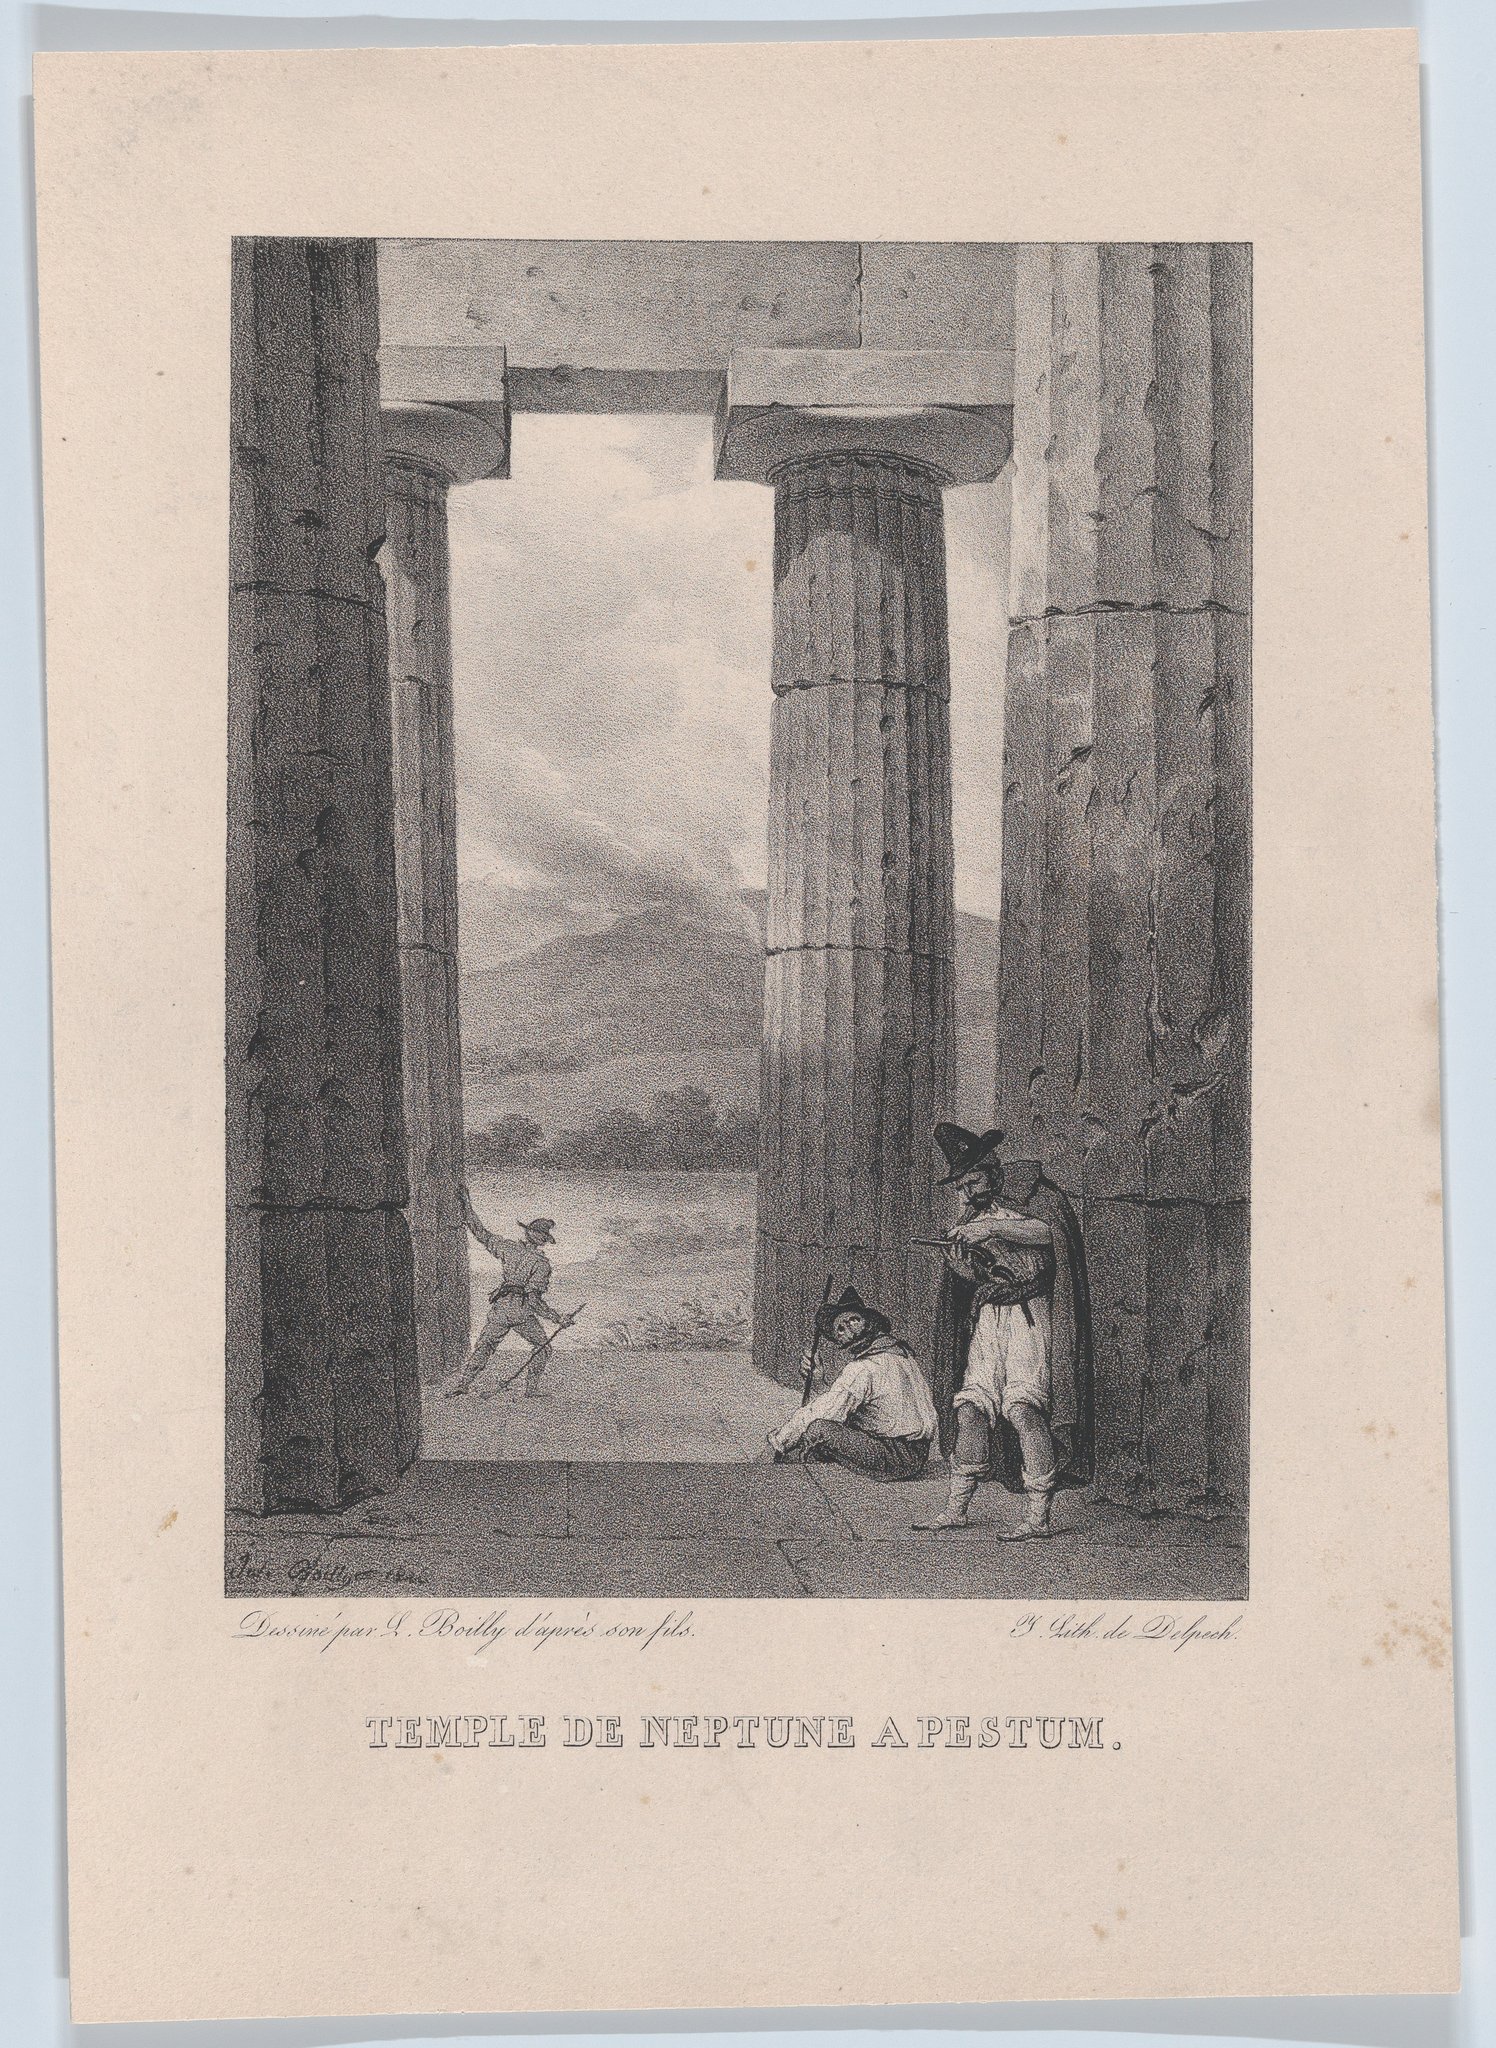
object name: print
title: The Temple of Neptune in Pestum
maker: louis léopold boilly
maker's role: artist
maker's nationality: french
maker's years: 1761-1845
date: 1826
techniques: lithograph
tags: columns,men